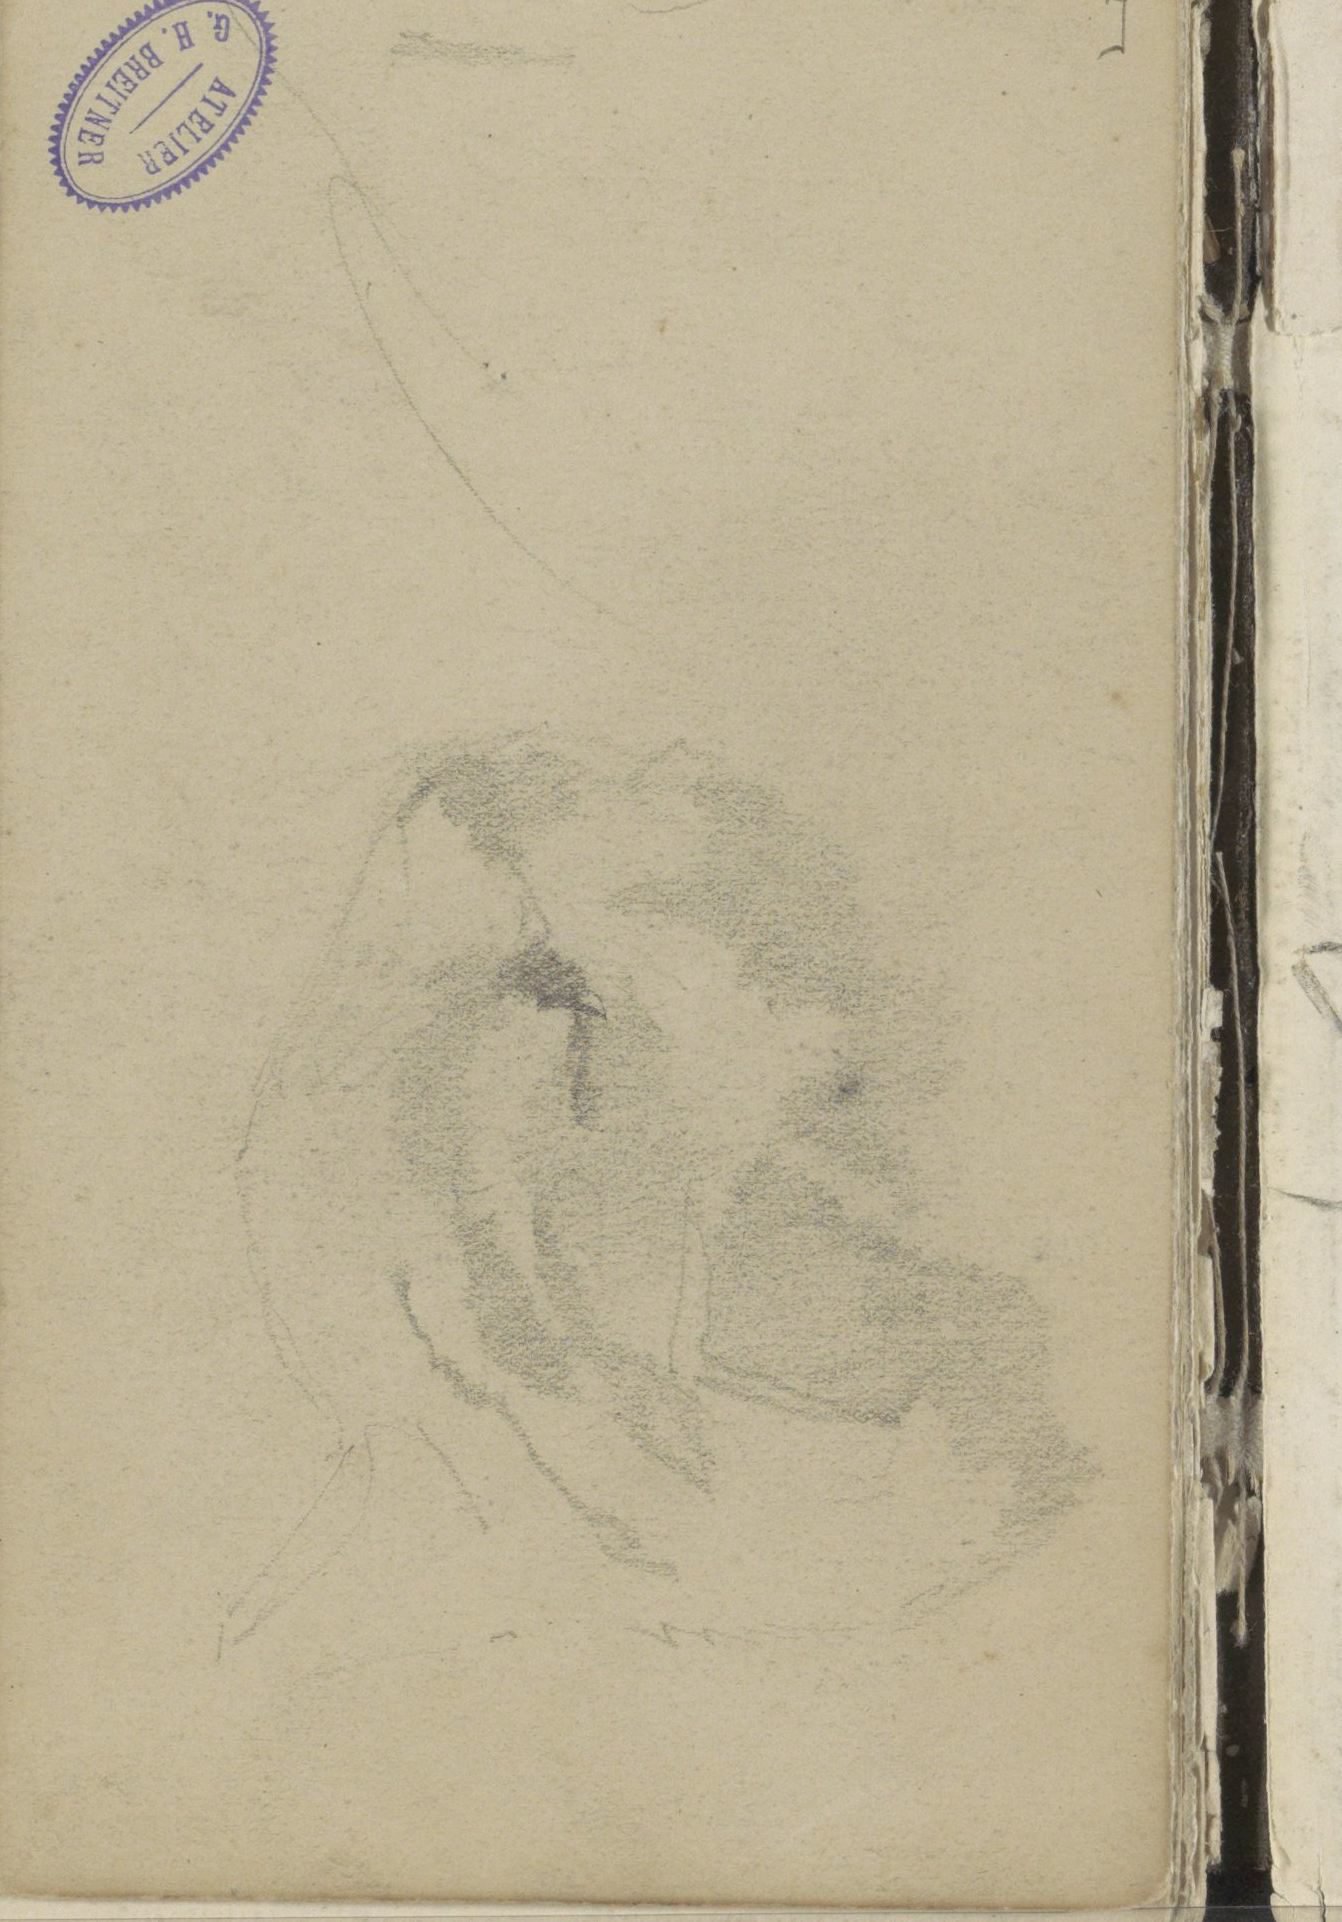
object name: sketchbook leaf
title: Kop van een dier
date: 1880-1882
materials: paper, pencil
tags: mammals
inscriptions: workshop stamp: Lugt 291d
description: Pagina J, los aangetroffen tussen blad 33 en het achterste schutblad in een schetsboek met 16 bladen.